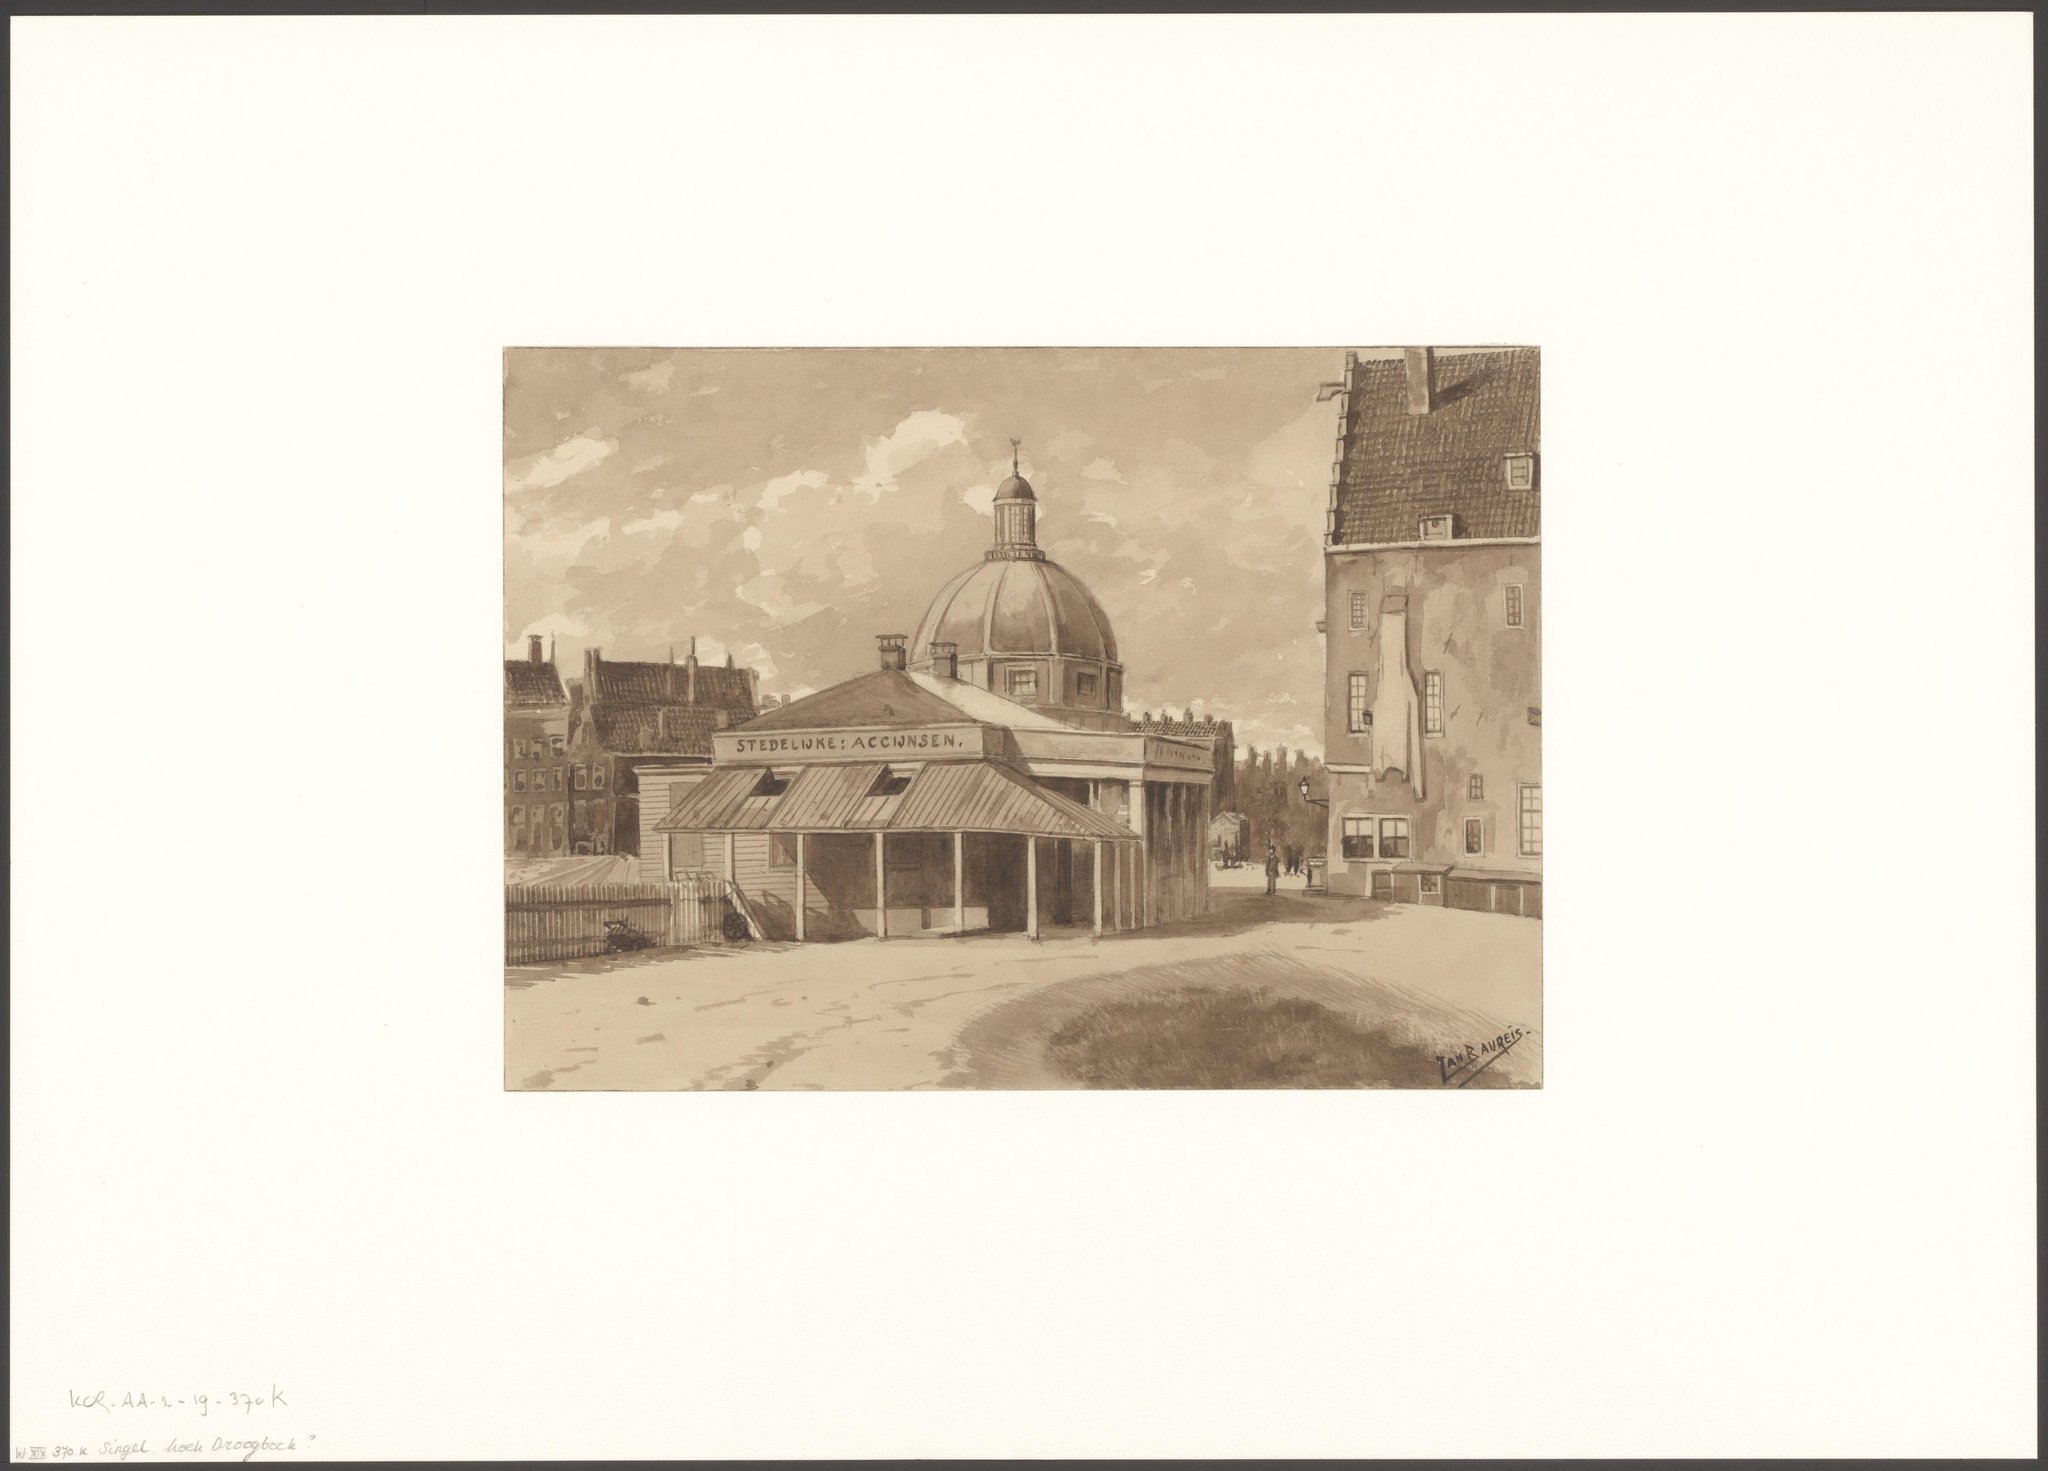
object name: drawing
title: Gezicht op de Ronde Lutherse Kerk vanaf Droogbak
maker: jan baureis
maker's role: draughtsman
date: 1850-1950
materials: ink, paper, pencil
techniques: brush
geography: amsterdam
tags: city-view in general; 'veduta', parts of church exterior and annexes: dome, street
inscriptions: signature: ‘JanBaureis’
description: Tekening binnen de Atlas Van Eck ingedeeld op wijknummer 19.